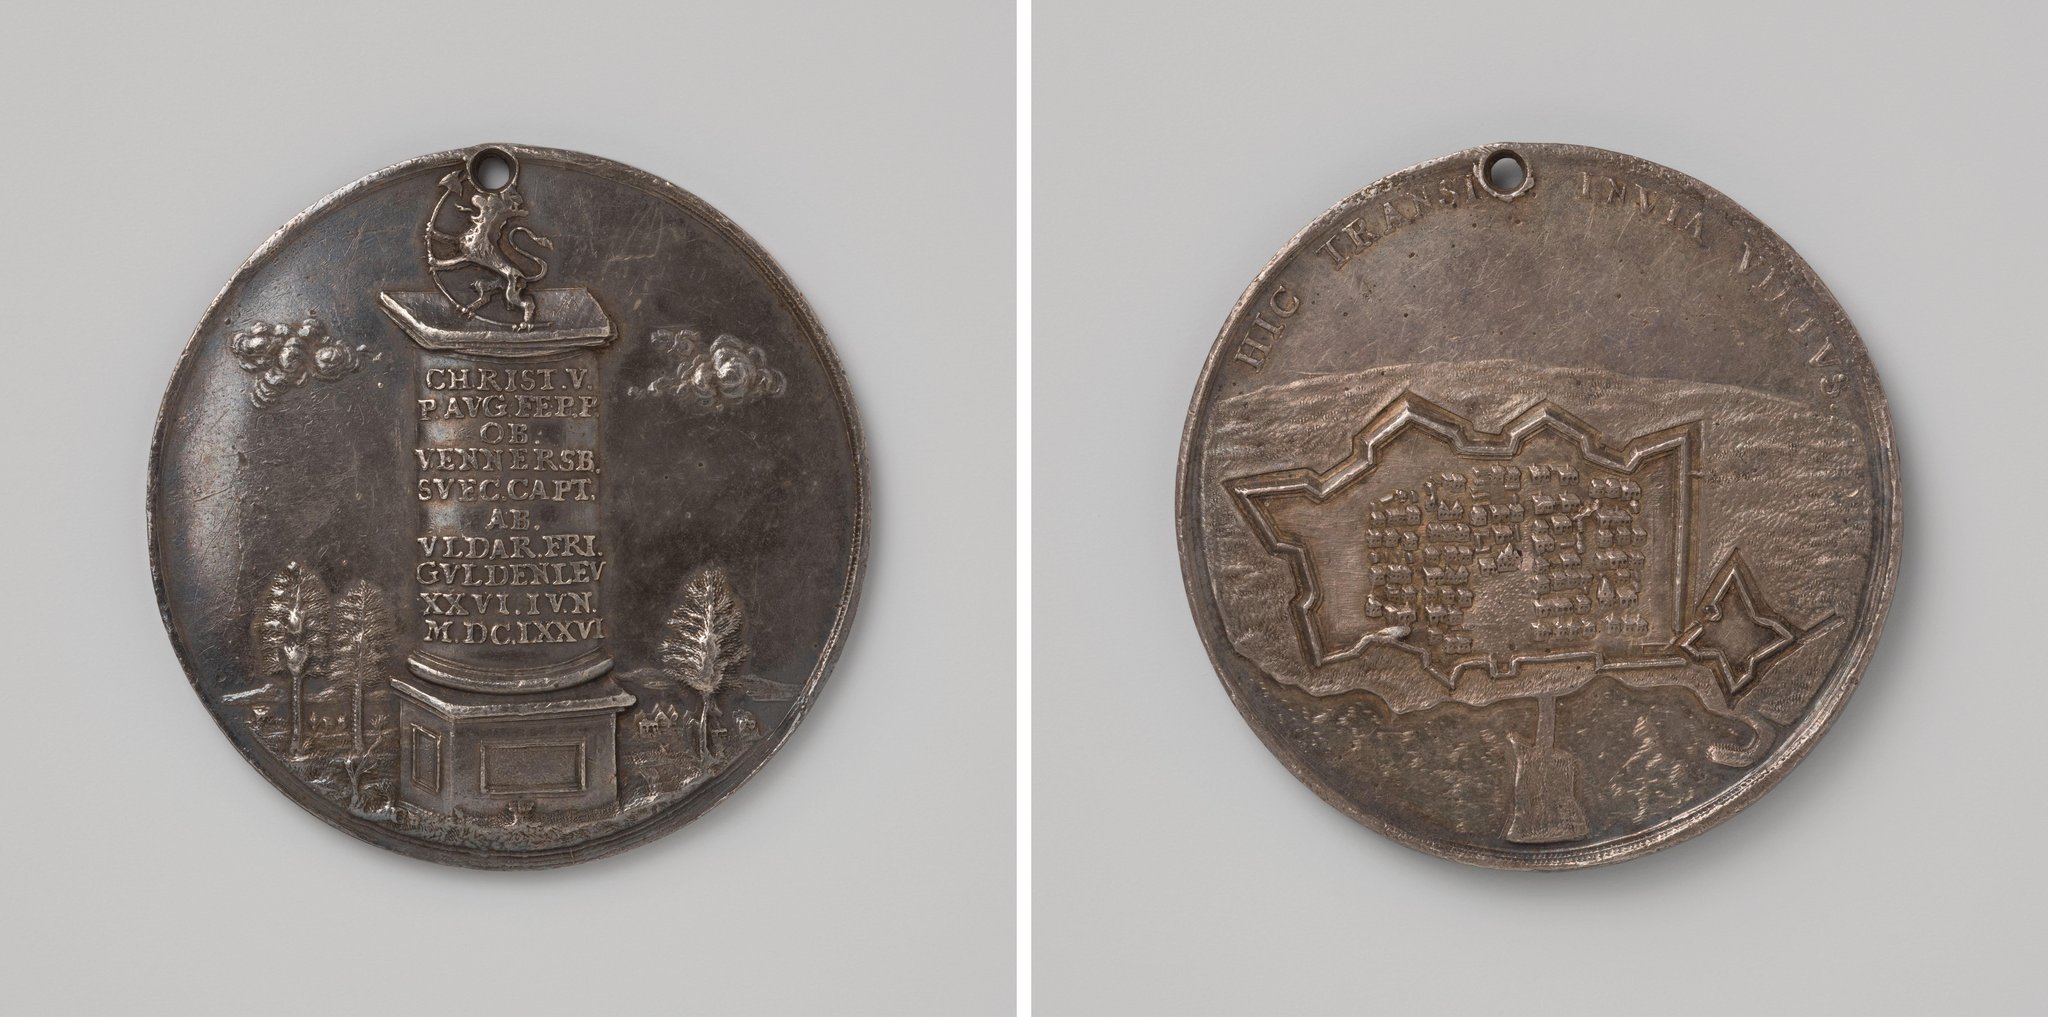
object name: history medal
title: Inname van Winnersburg door de hertog van Guldenleeuw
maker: Anonymous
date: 1676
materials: silver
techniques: striking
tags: earl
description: Zilveren penning met gat erin. Voorzijde: plattegrond van de vesting binnen omschrift. Keerzijde: leeuw met bijl op een pilaar met opschrift